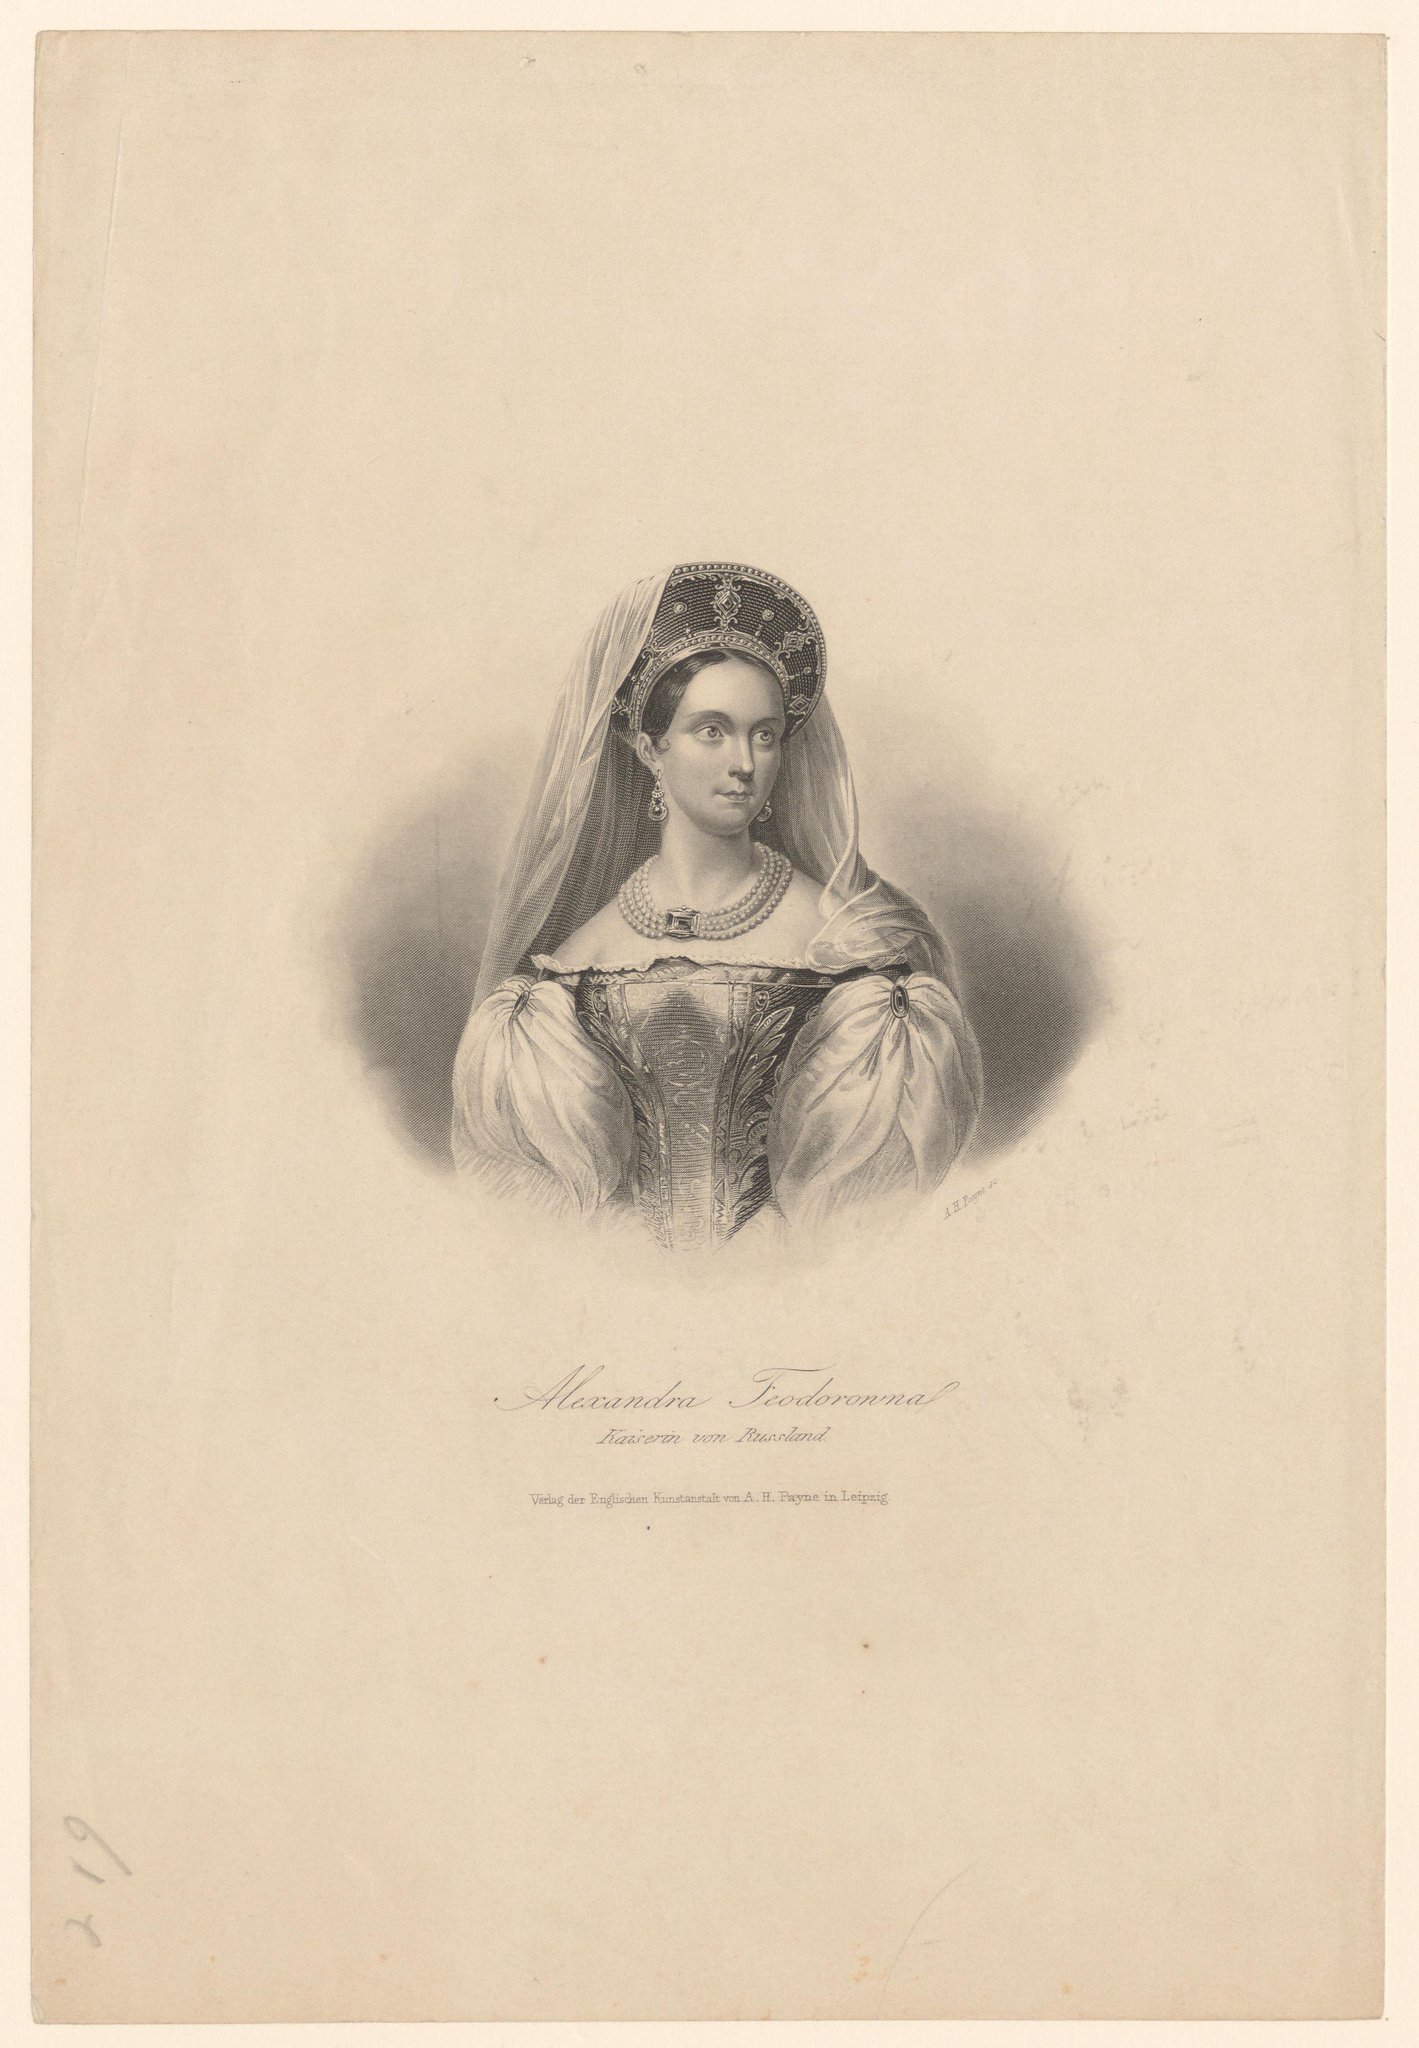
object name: print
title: Alexandra Feodorowna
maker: albert henry payne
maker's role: print maker, publisher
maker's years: 1812-1902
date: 1845-1855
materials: paper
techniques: engraving, etching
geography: leipzig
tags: berlin, queen, empress, etc. (wife of a ruler), historical persons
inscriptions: collector's mark: Lugt 2228